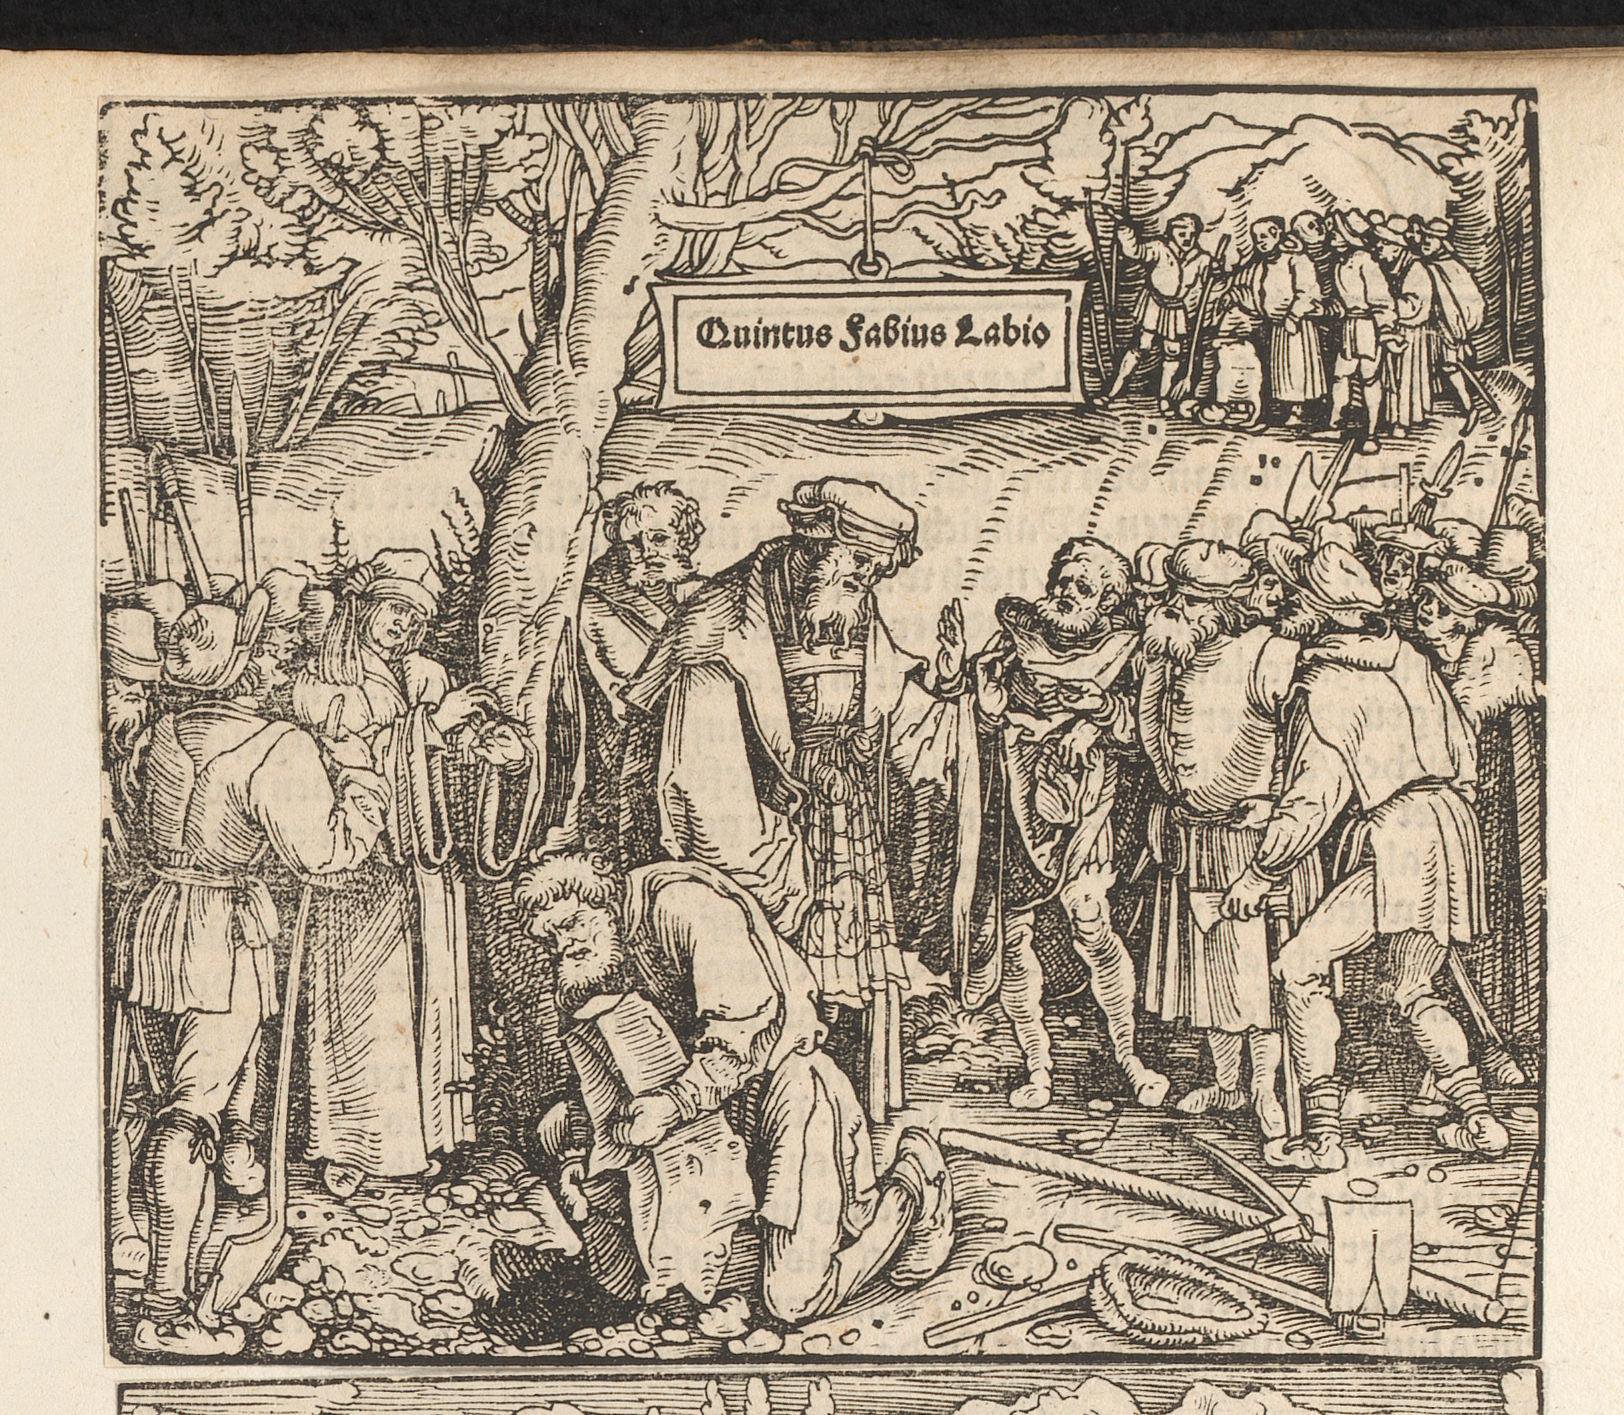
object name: print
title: Quintus Fabius Labio bemiddelt in het conflict over de grens tussen Napels en Nola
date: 1514-1531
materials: paper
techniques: letterpress printing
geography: augsburg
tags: events and situations from classical history (punic war), milestone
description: Deze prent is gebruikt in: Cicero, Marcus Tulius. Officia M.T.C. Ein Buch so Marcus Tullius Cicero der Römer zu seynem (...). [Vertaald uit het Latijn door] Johann von Schwarzenberg. Augsburg: Heinrich Steiner, 1531.